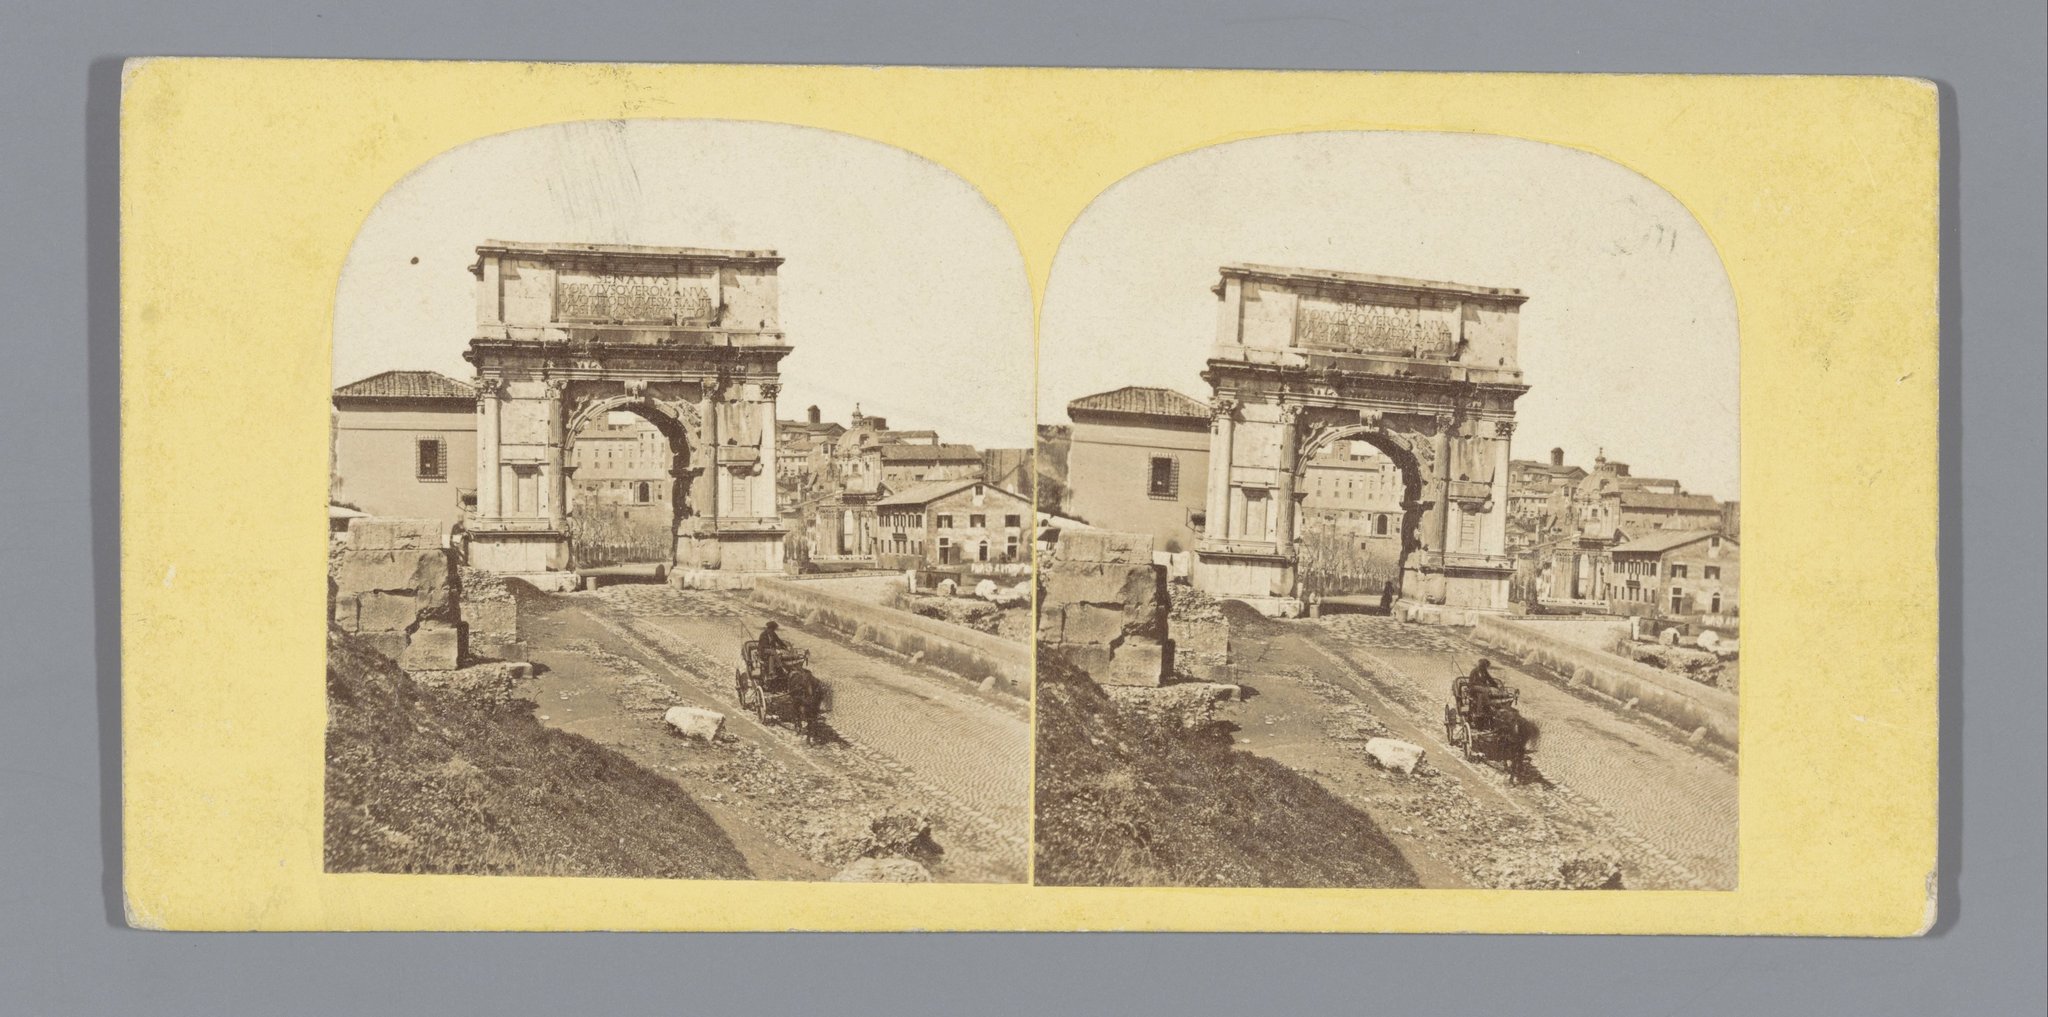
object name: stereograph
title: Gezicht op de Boog van Titus te Rome, met op de voorgrond een paardenkoets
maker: Anonymous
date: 1850-1880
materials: cardboard, photographic support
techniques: albumen print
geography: forum romanum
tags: triumphal arch, four-wheeled, animal-drawn vehicle, e.g.: cab, carriage, coach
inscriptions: inscription: ‘Arc de Titus Rome’